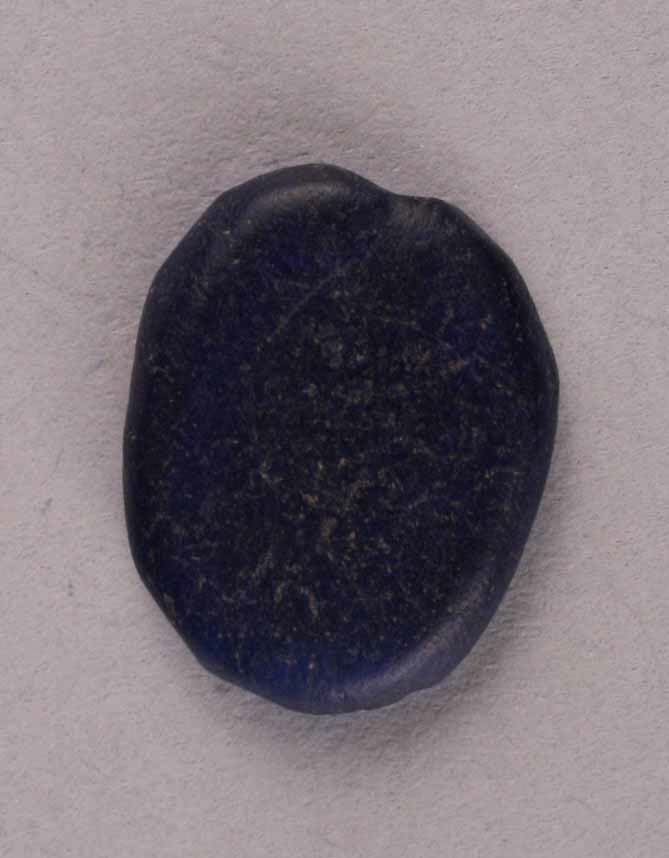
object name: bead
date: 701-1000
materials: glass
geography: iran